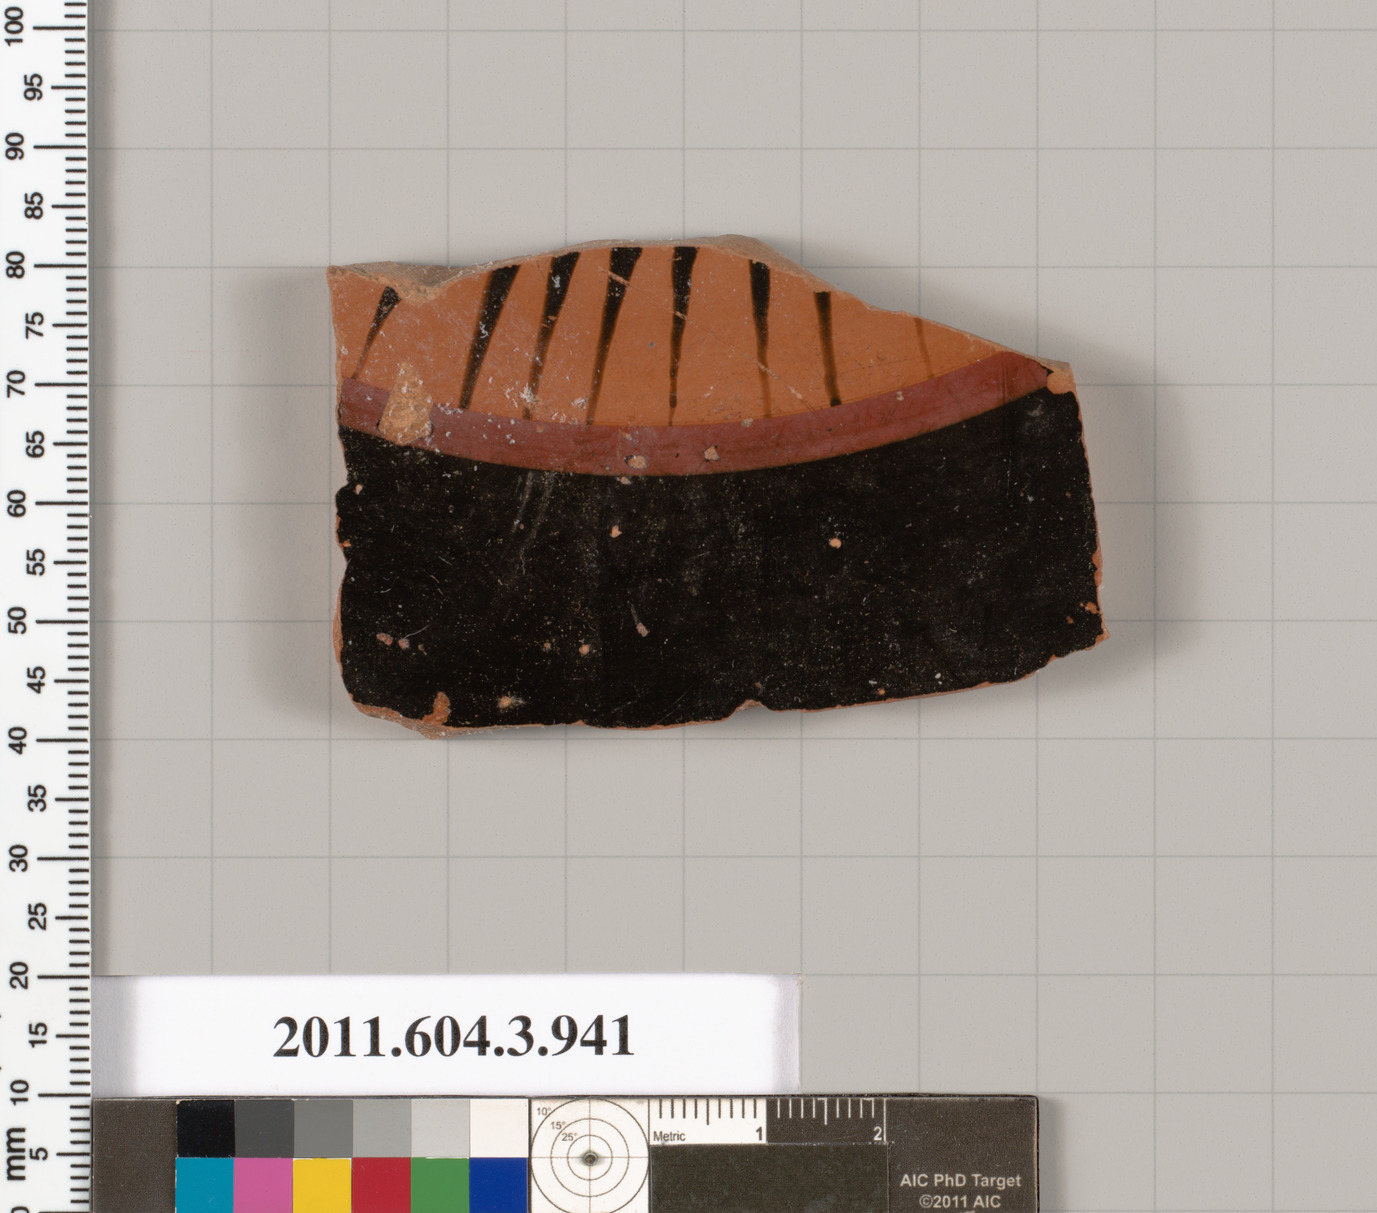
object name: lekanis lid fragment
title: Terracotta fragment of a lekanis lid (covered dish)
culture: greek, attic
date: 600-501 BCE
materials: terracotta